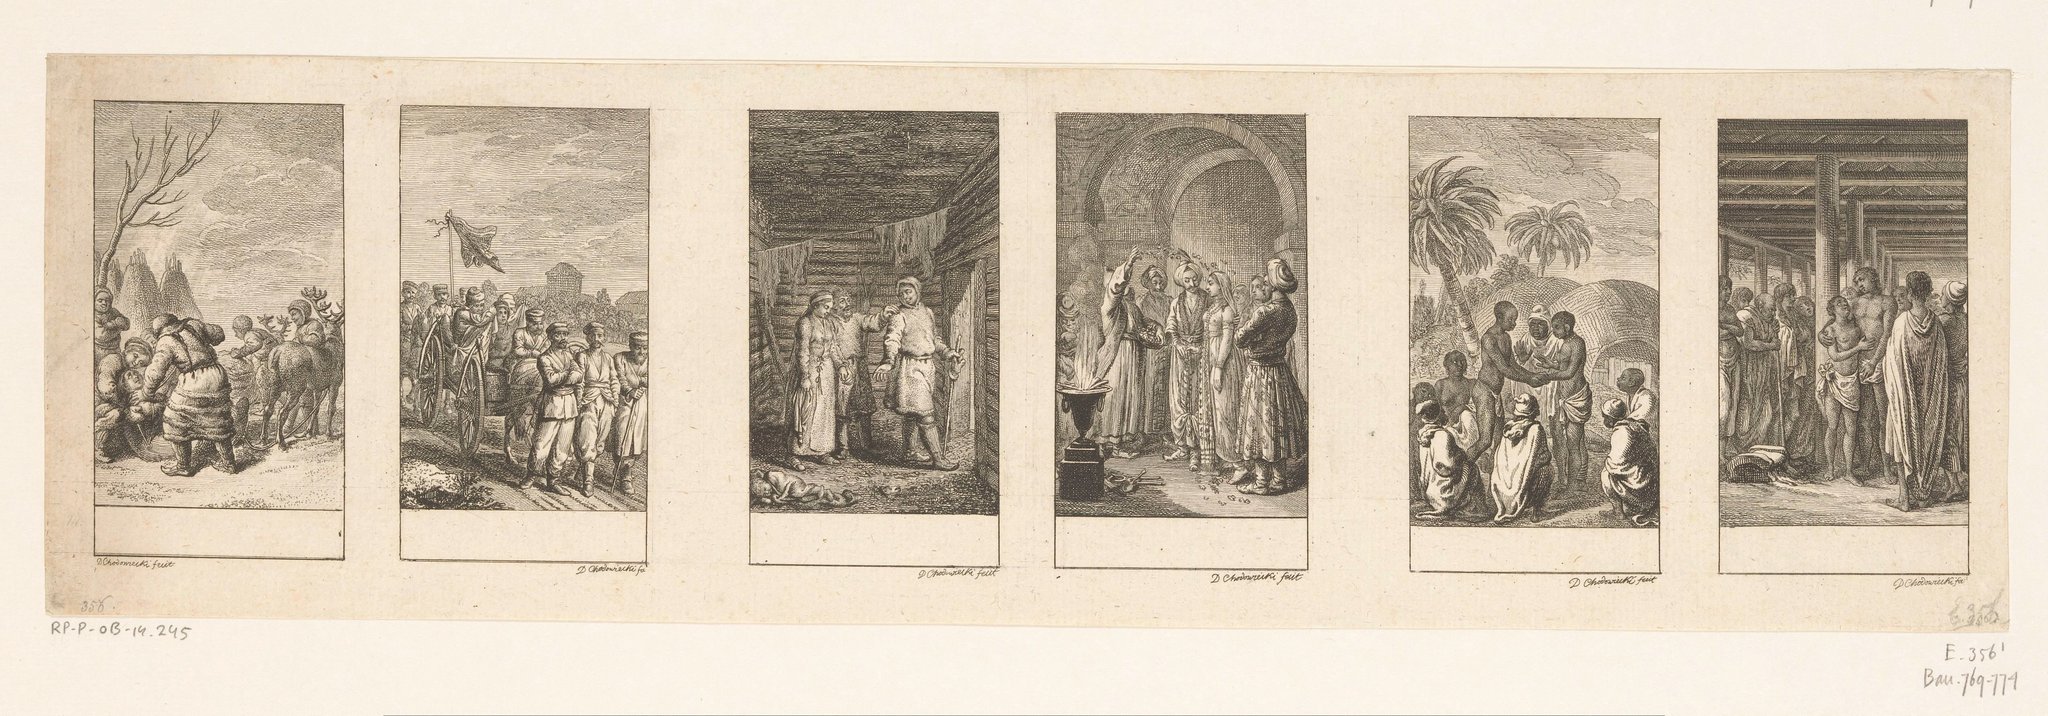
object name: print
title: Zes voorstellingen met huwelijksgebruiken bij verschillende volkeren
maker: daniel nikolaus chodowiecki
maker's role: draughtsman, print maker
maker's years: 1726-1801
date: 1780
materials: paper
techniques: etching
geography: berlin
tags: hinduism, buddhism, jainism, asiatic races and peoples: turks, chinese, europeans (with name), africans, japanese, (civil) marriage ceremonies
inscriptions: collector's mark: Lugt 2228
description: Van links naar rechts; het Samojeedse huwelijk, het Kozakken huwelijk, het Osteakern huwelijk (?), het Parsi huwelijk, het Khoikhoi huwelijk en het Tahitiaanse huwelijk.